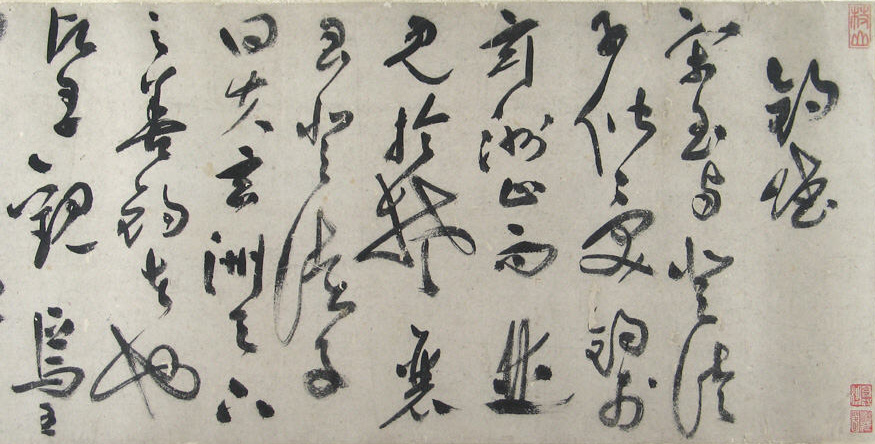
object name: handscroll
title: Prose Poem on Fishing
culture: chinese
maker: zhu yunming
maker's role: artist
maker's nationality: chinese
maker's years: 1461-1527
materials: gold, ink, paper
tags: poetry